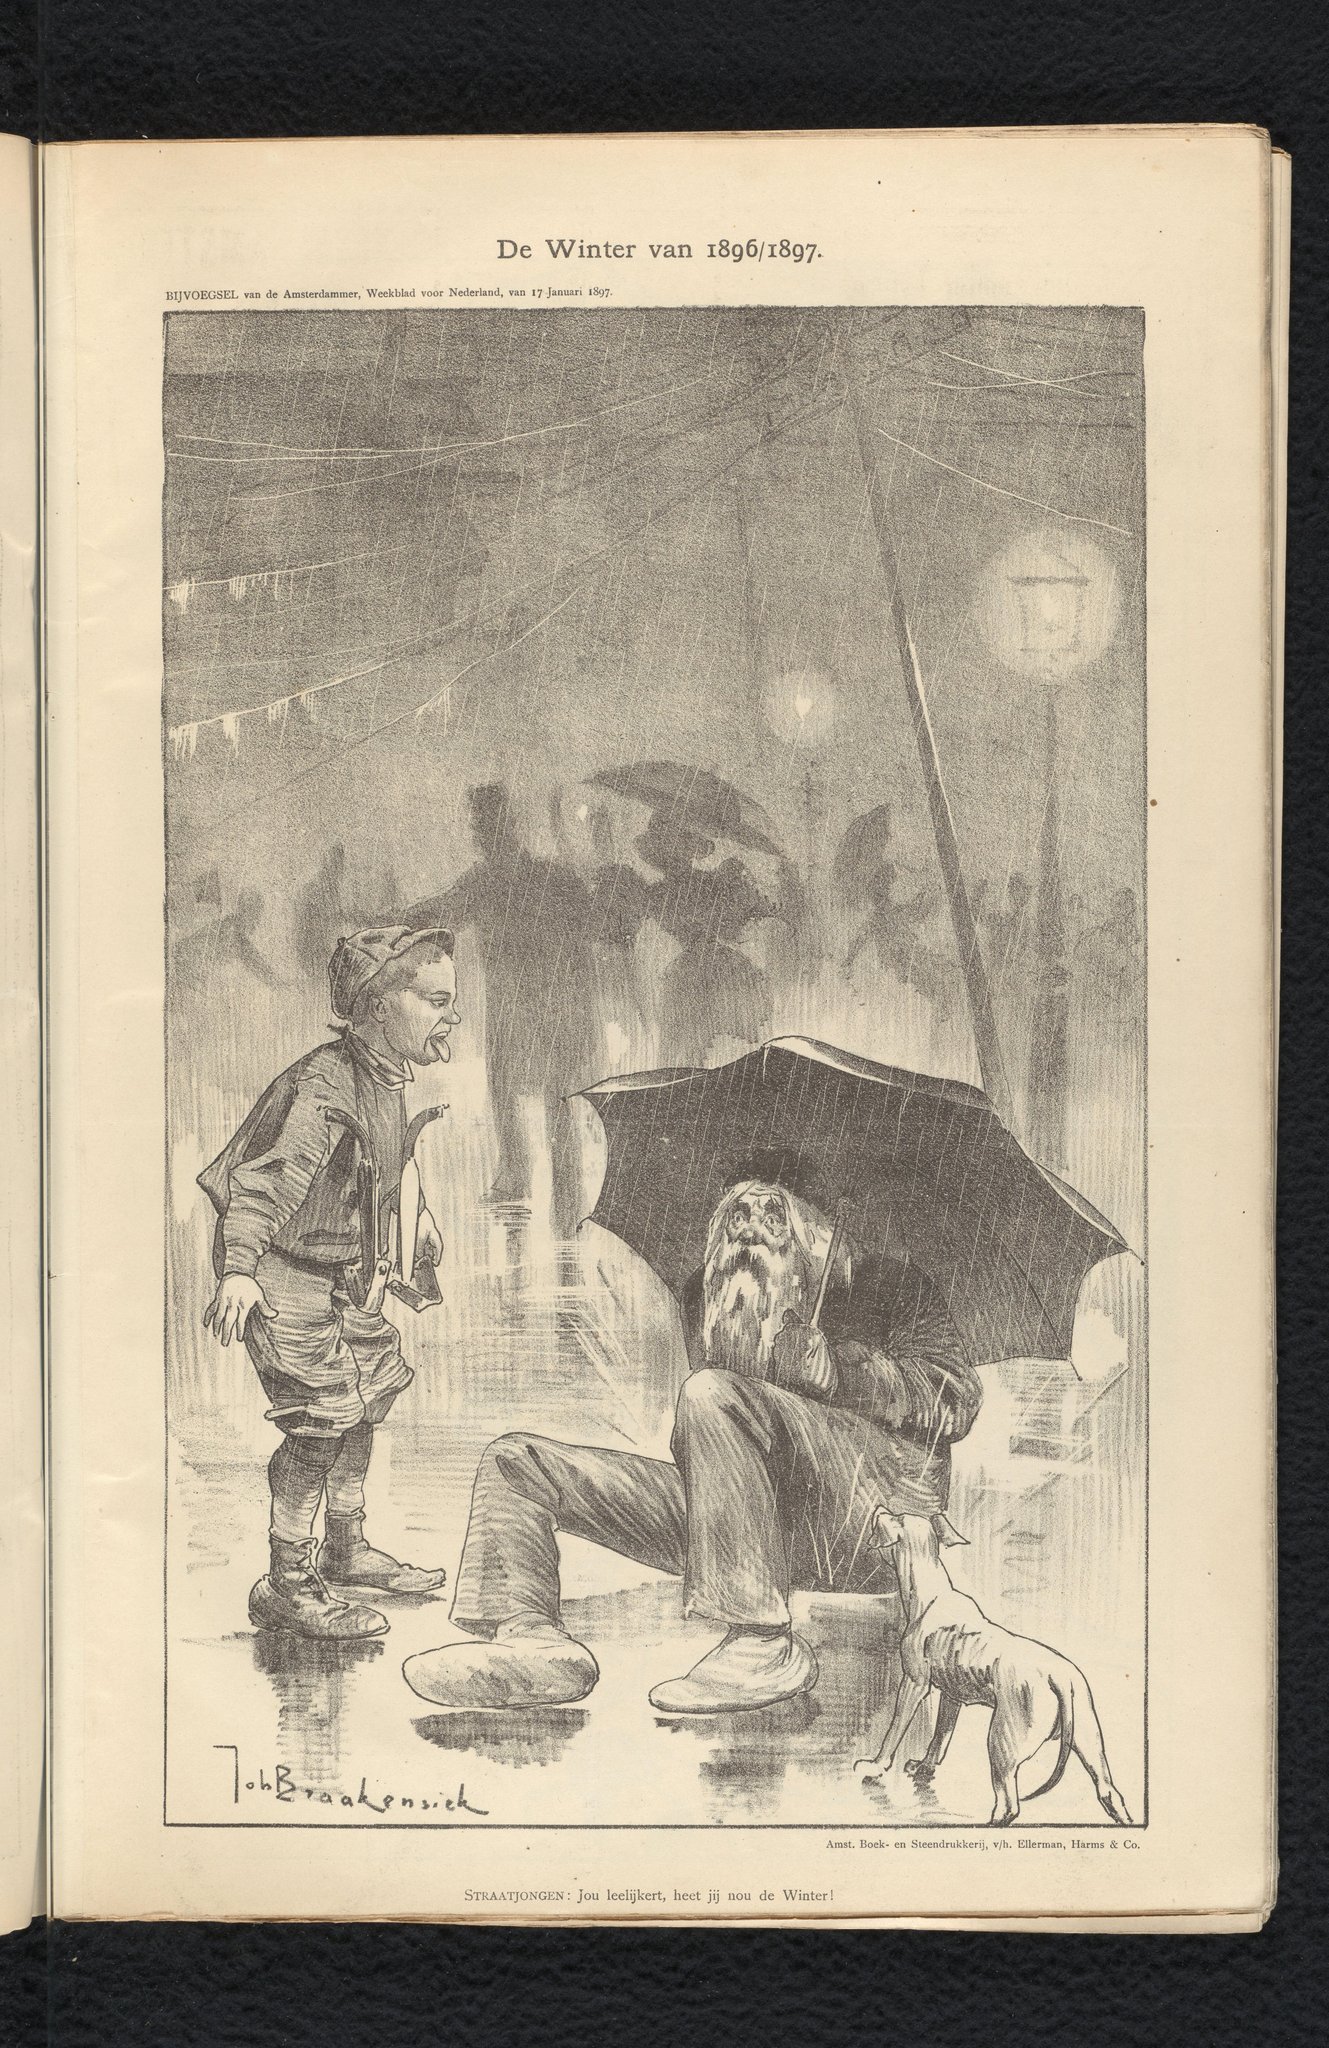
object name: cartoon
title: De Winter van 1896/1897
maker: johan braakensiek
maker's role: draughtsman, print maker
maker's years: 1858-1940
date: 1897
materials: paper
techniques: lithograph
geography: netherlands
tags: winter, 'hyems'; 'inverno' (ripa), ice ~ freezing weather, political caricatures and satires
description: Jongetje steekt zijn tong uit naar een oude man (de Winter) met paraplu die op de gladde straat is uitgegleden.